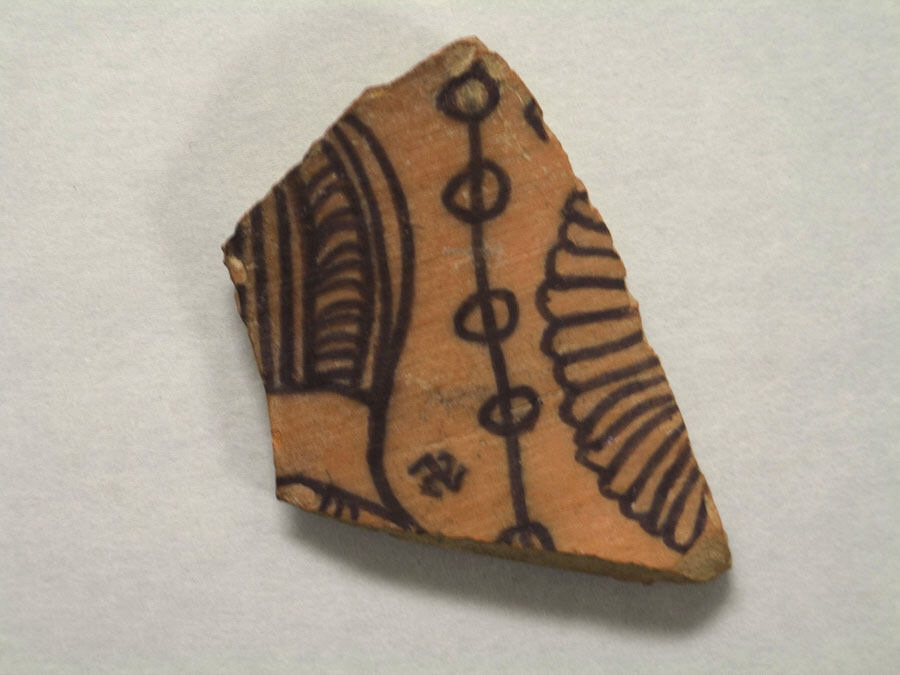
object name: shard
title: Shard: Lotus Flower (Partial with Costume Fragment?)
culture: pakistani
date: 301-500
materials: terracotta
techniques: painting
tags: gandhara